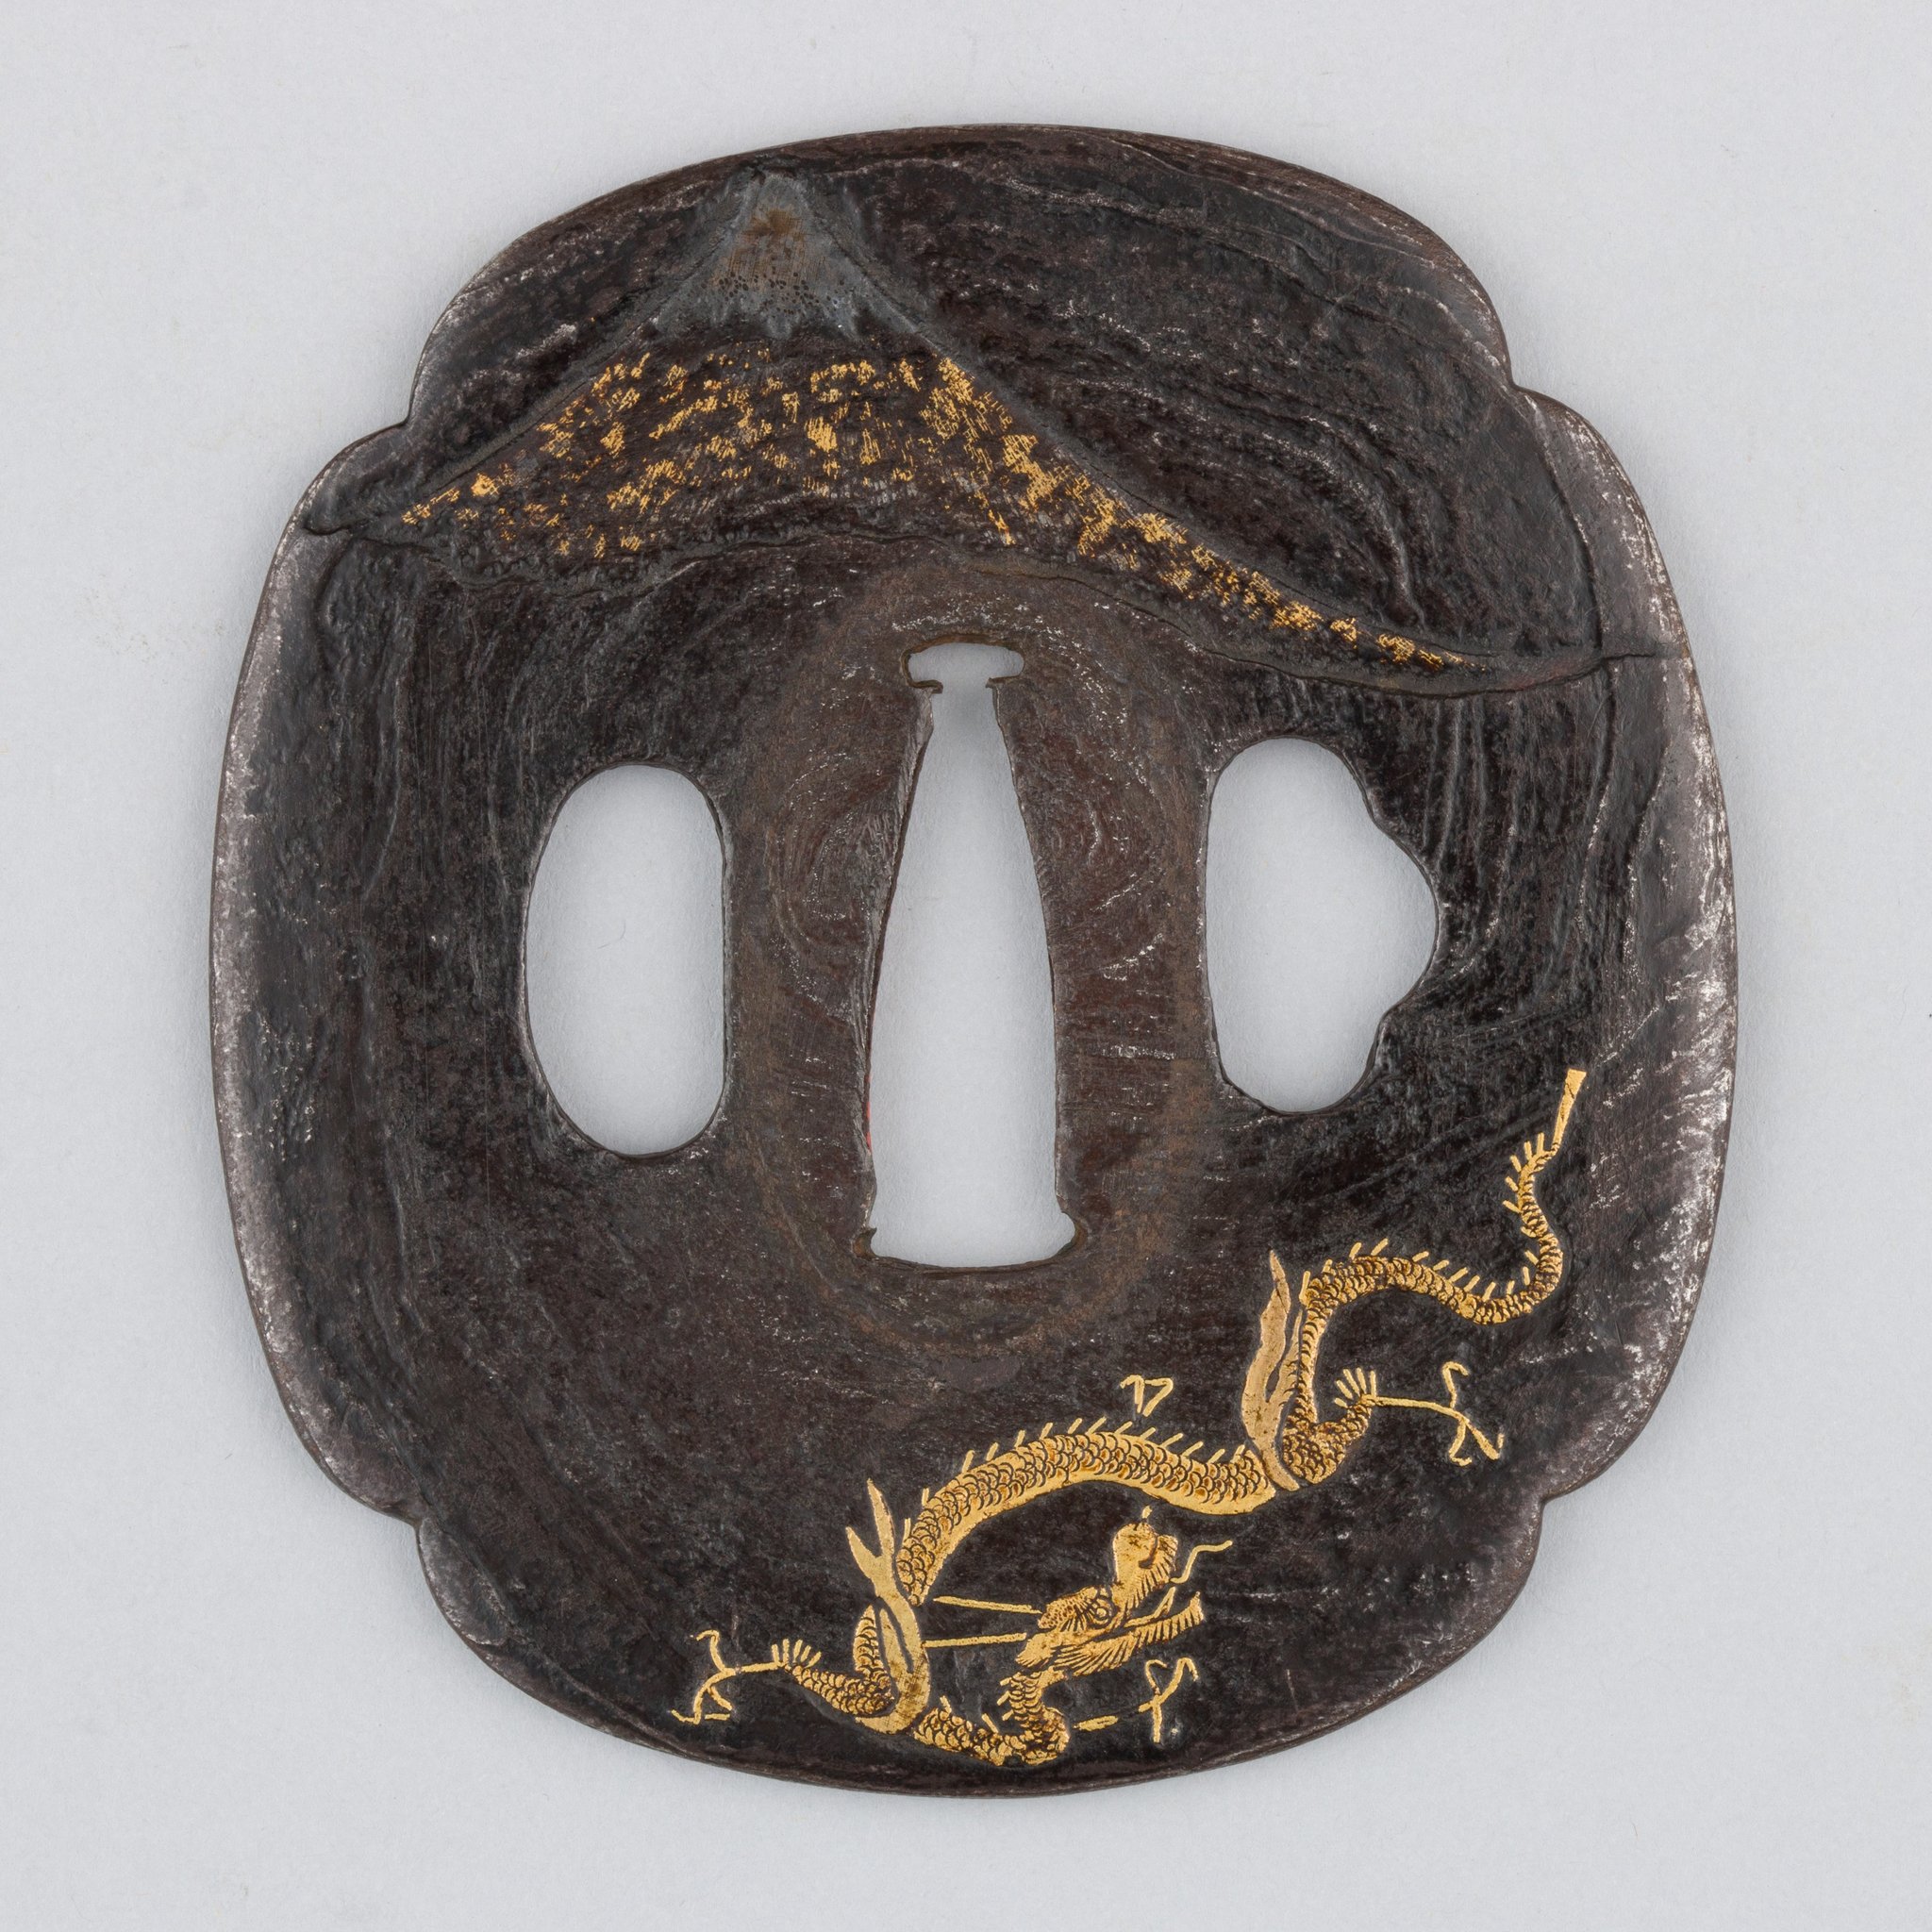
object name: sword guard tsuba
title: Sword Guard (Tsuba)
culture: japanese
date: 1701-1800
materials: copper, gold, iron, silver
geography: japan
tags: dragons,mountains